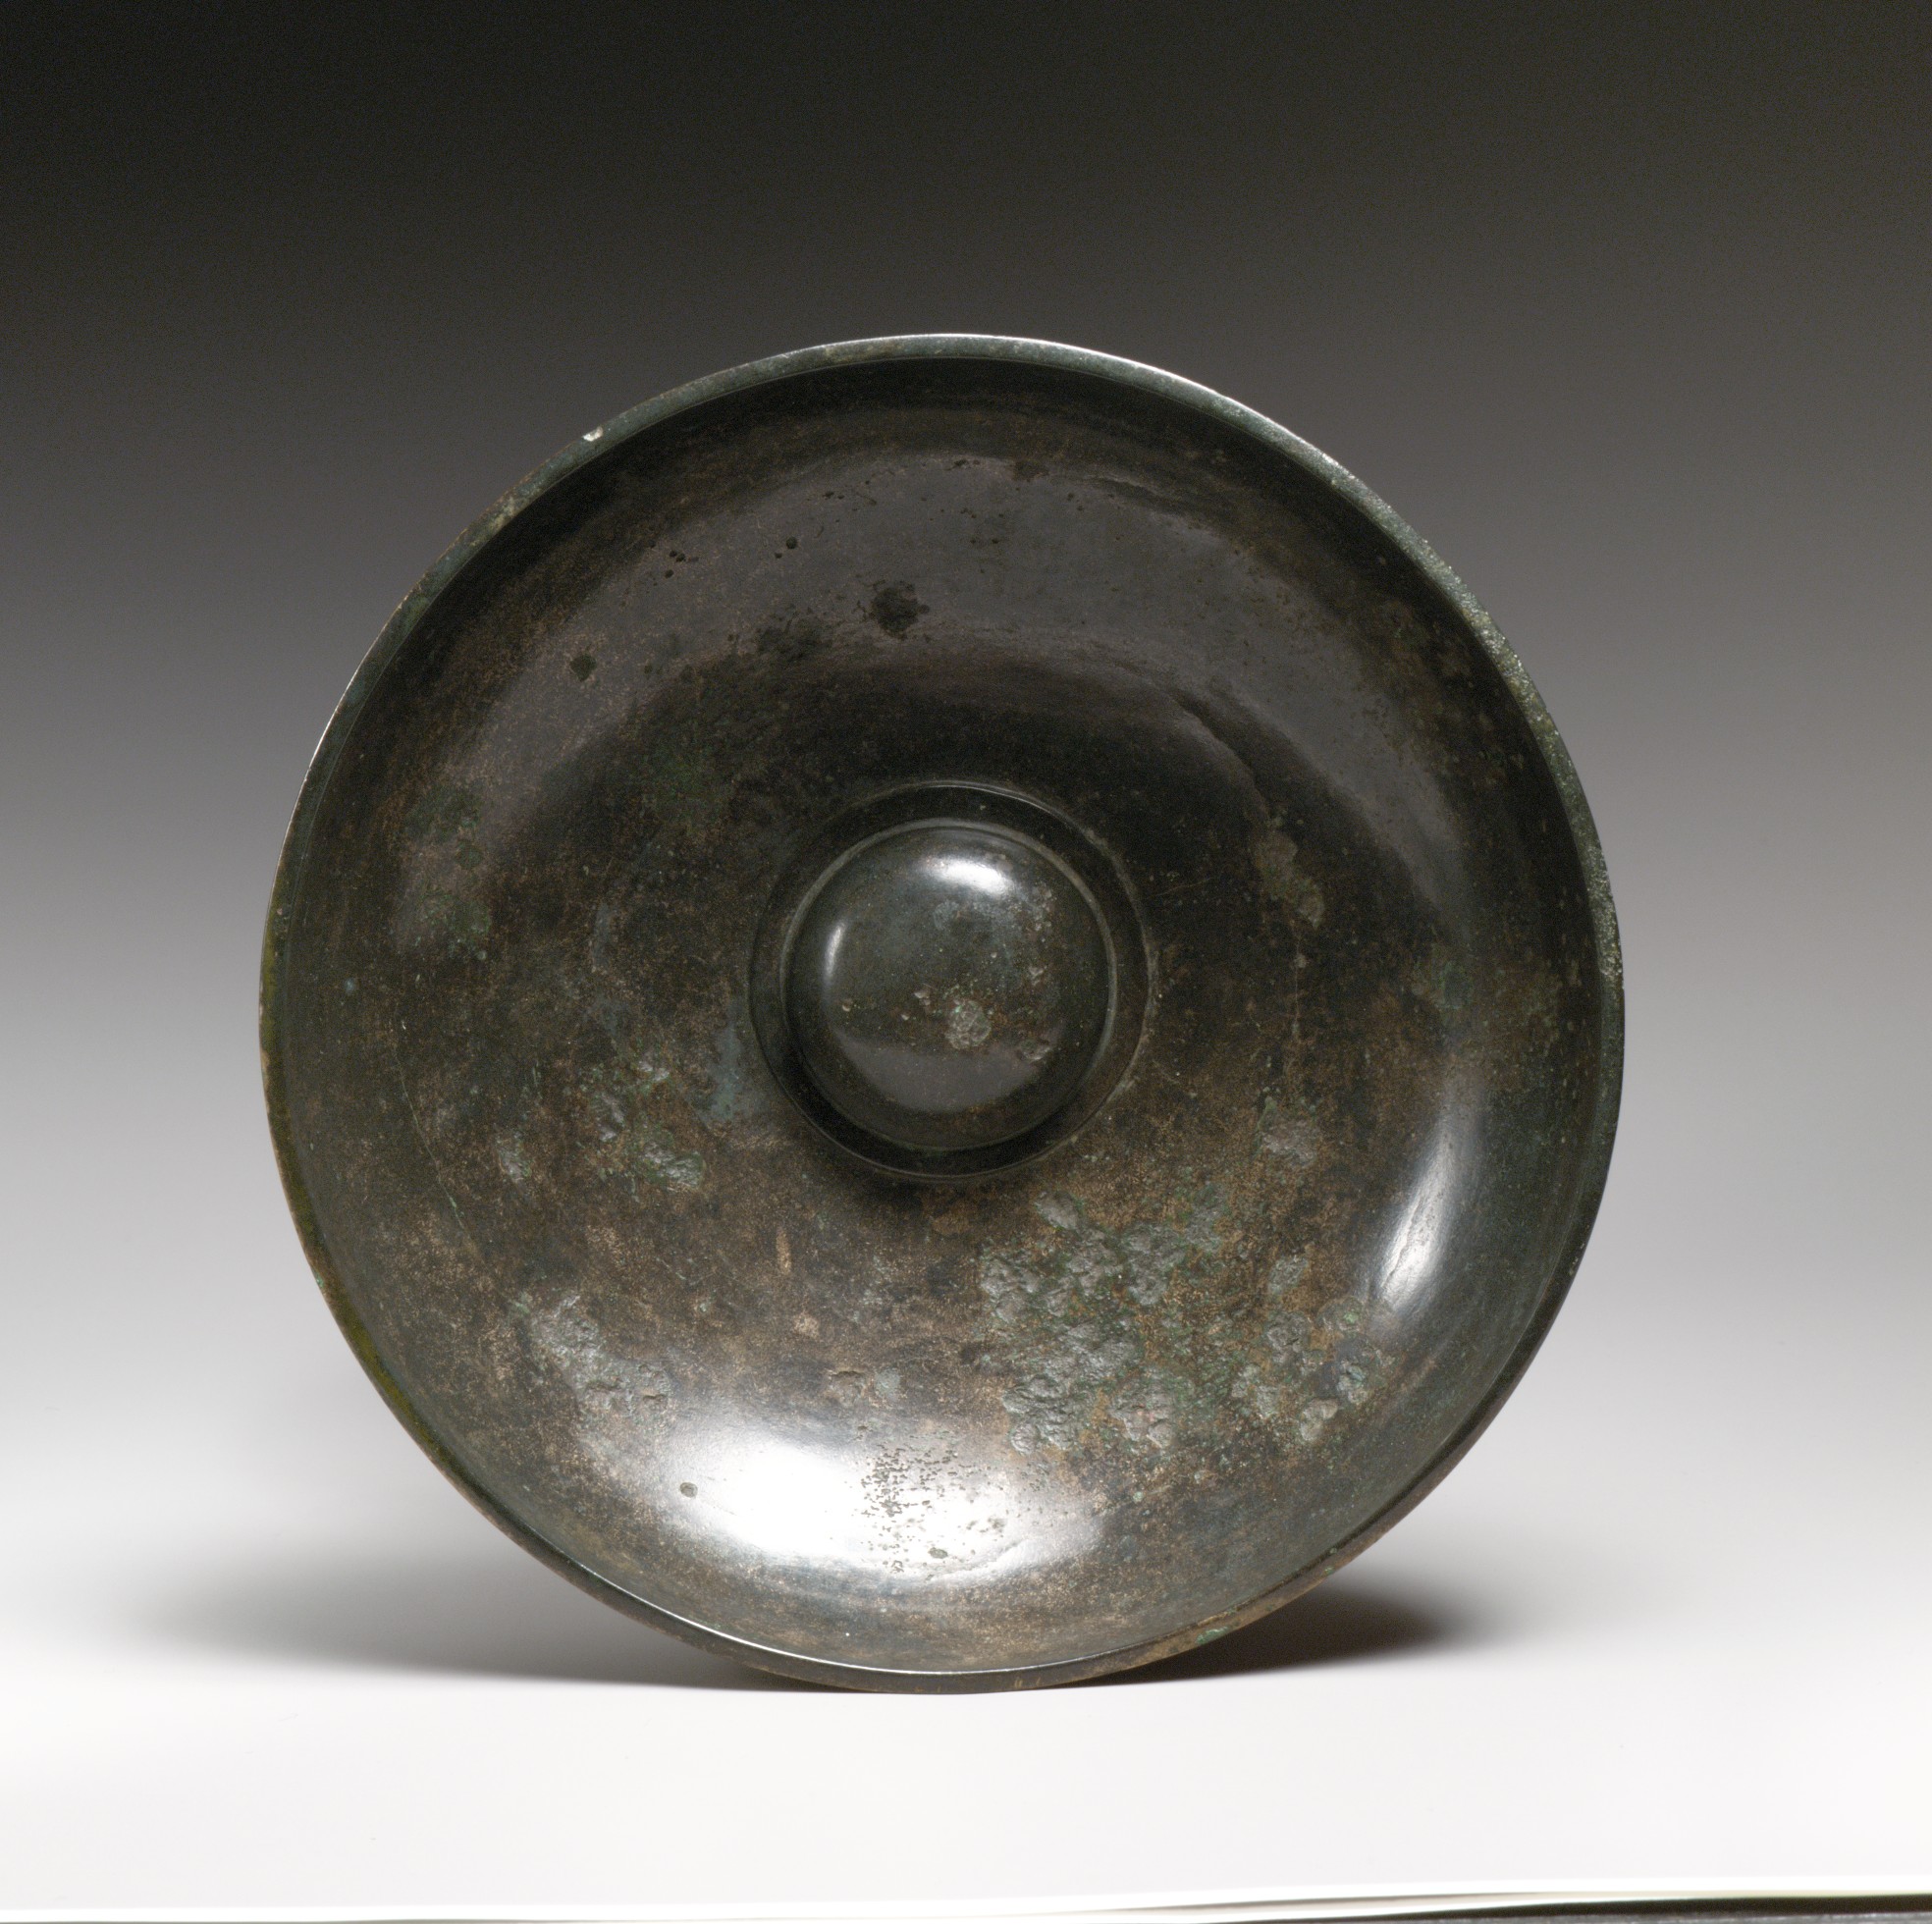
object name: phiale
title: Bronze phiale (libation bowl)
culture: phrygian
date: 700-601 BCE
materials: bronze